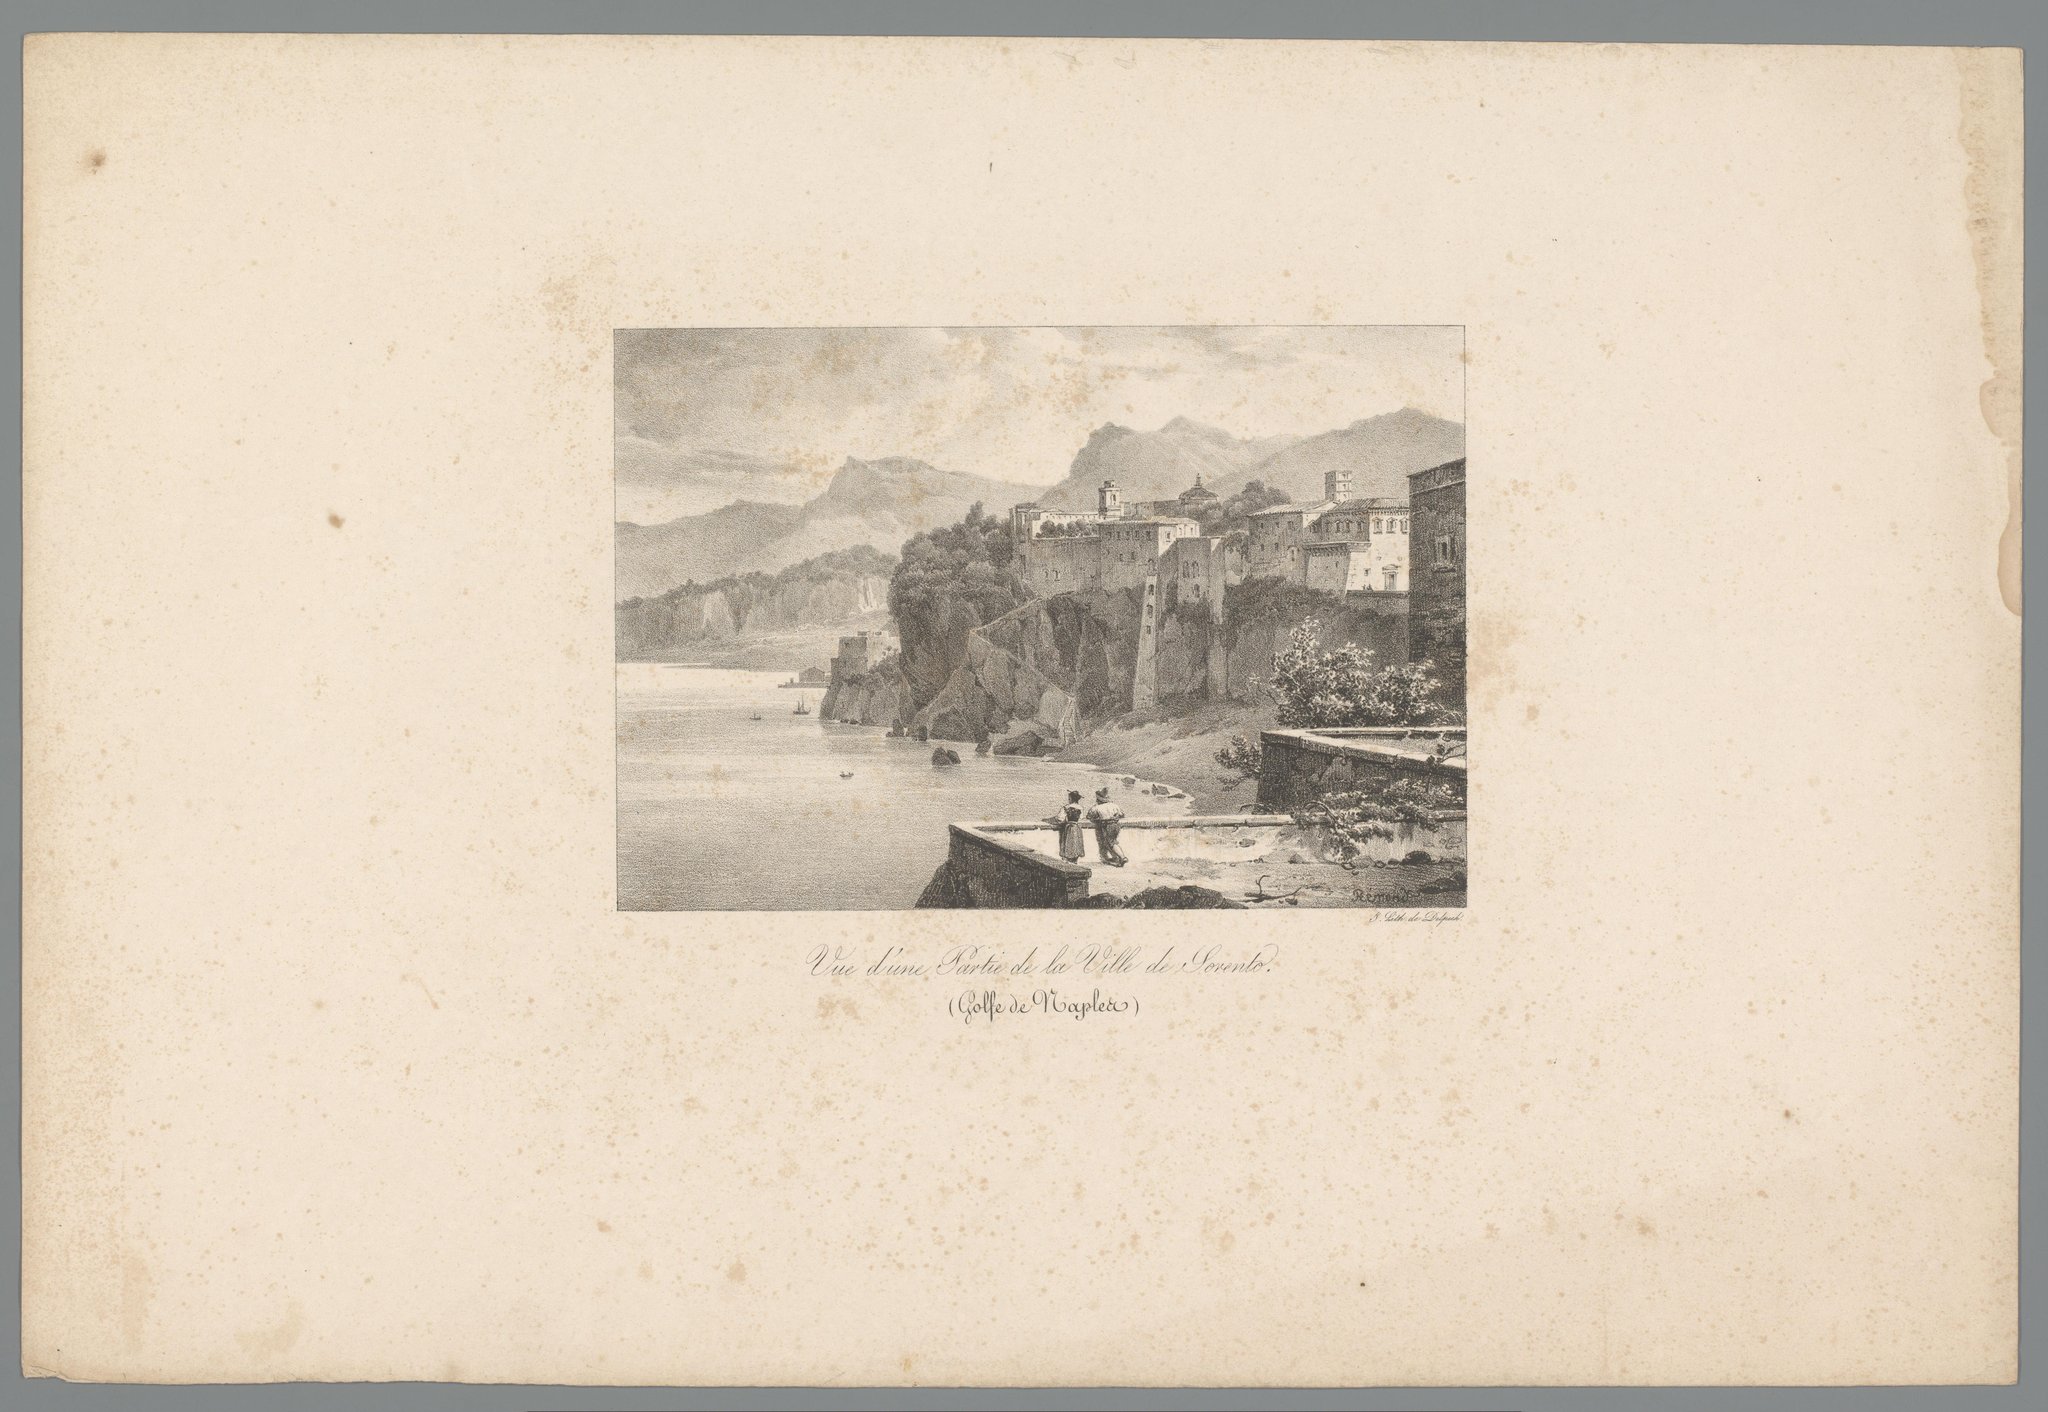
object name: print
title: Vue d'une partie de la ville de Sorento. (Golfe de Naples)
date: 1827-1828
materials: paper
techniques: lithograph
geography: paris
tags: city-view in general; 'veduta', sorrento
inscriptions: collector's mark: Lugt 2228